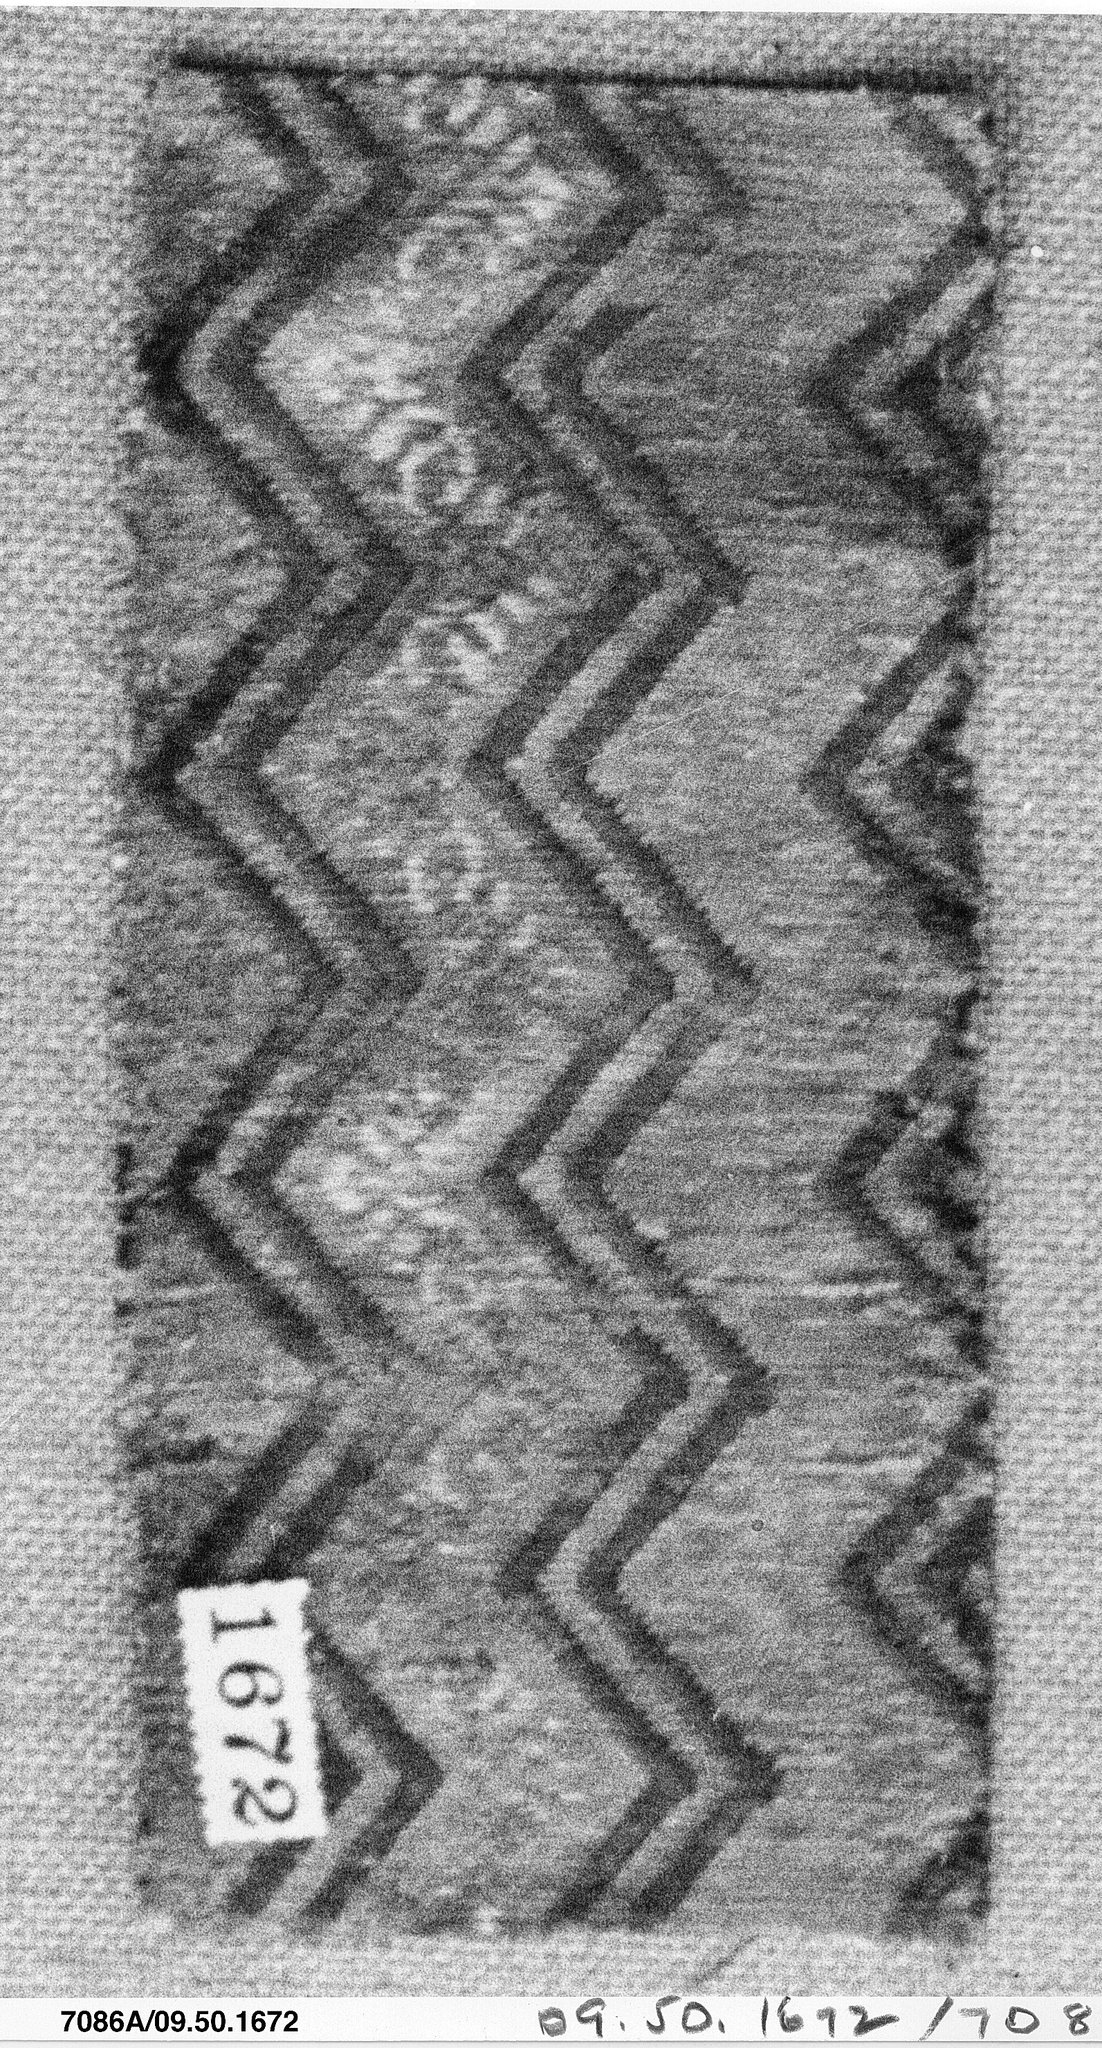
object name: piece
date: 1701-1800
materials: metal thread, silk